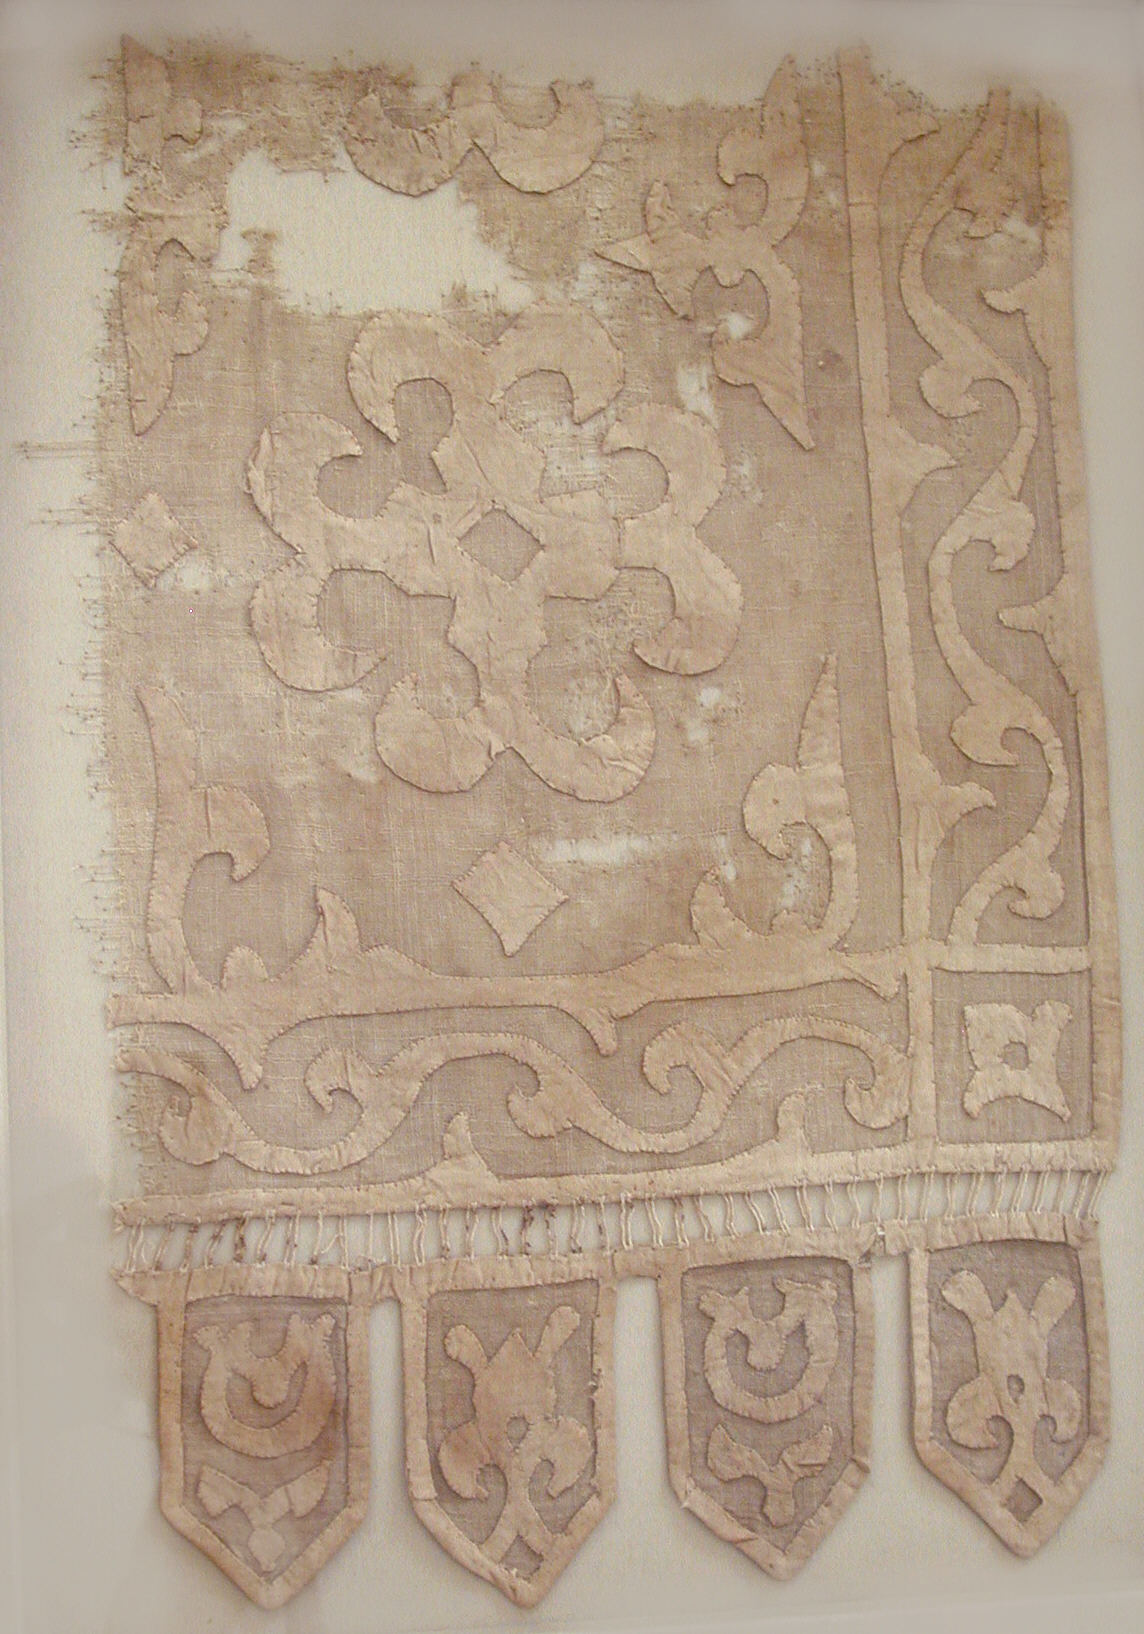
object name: textile fragment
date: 1201-1400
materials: linen, metal thread, silk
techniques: appliqué, weave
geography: egypt